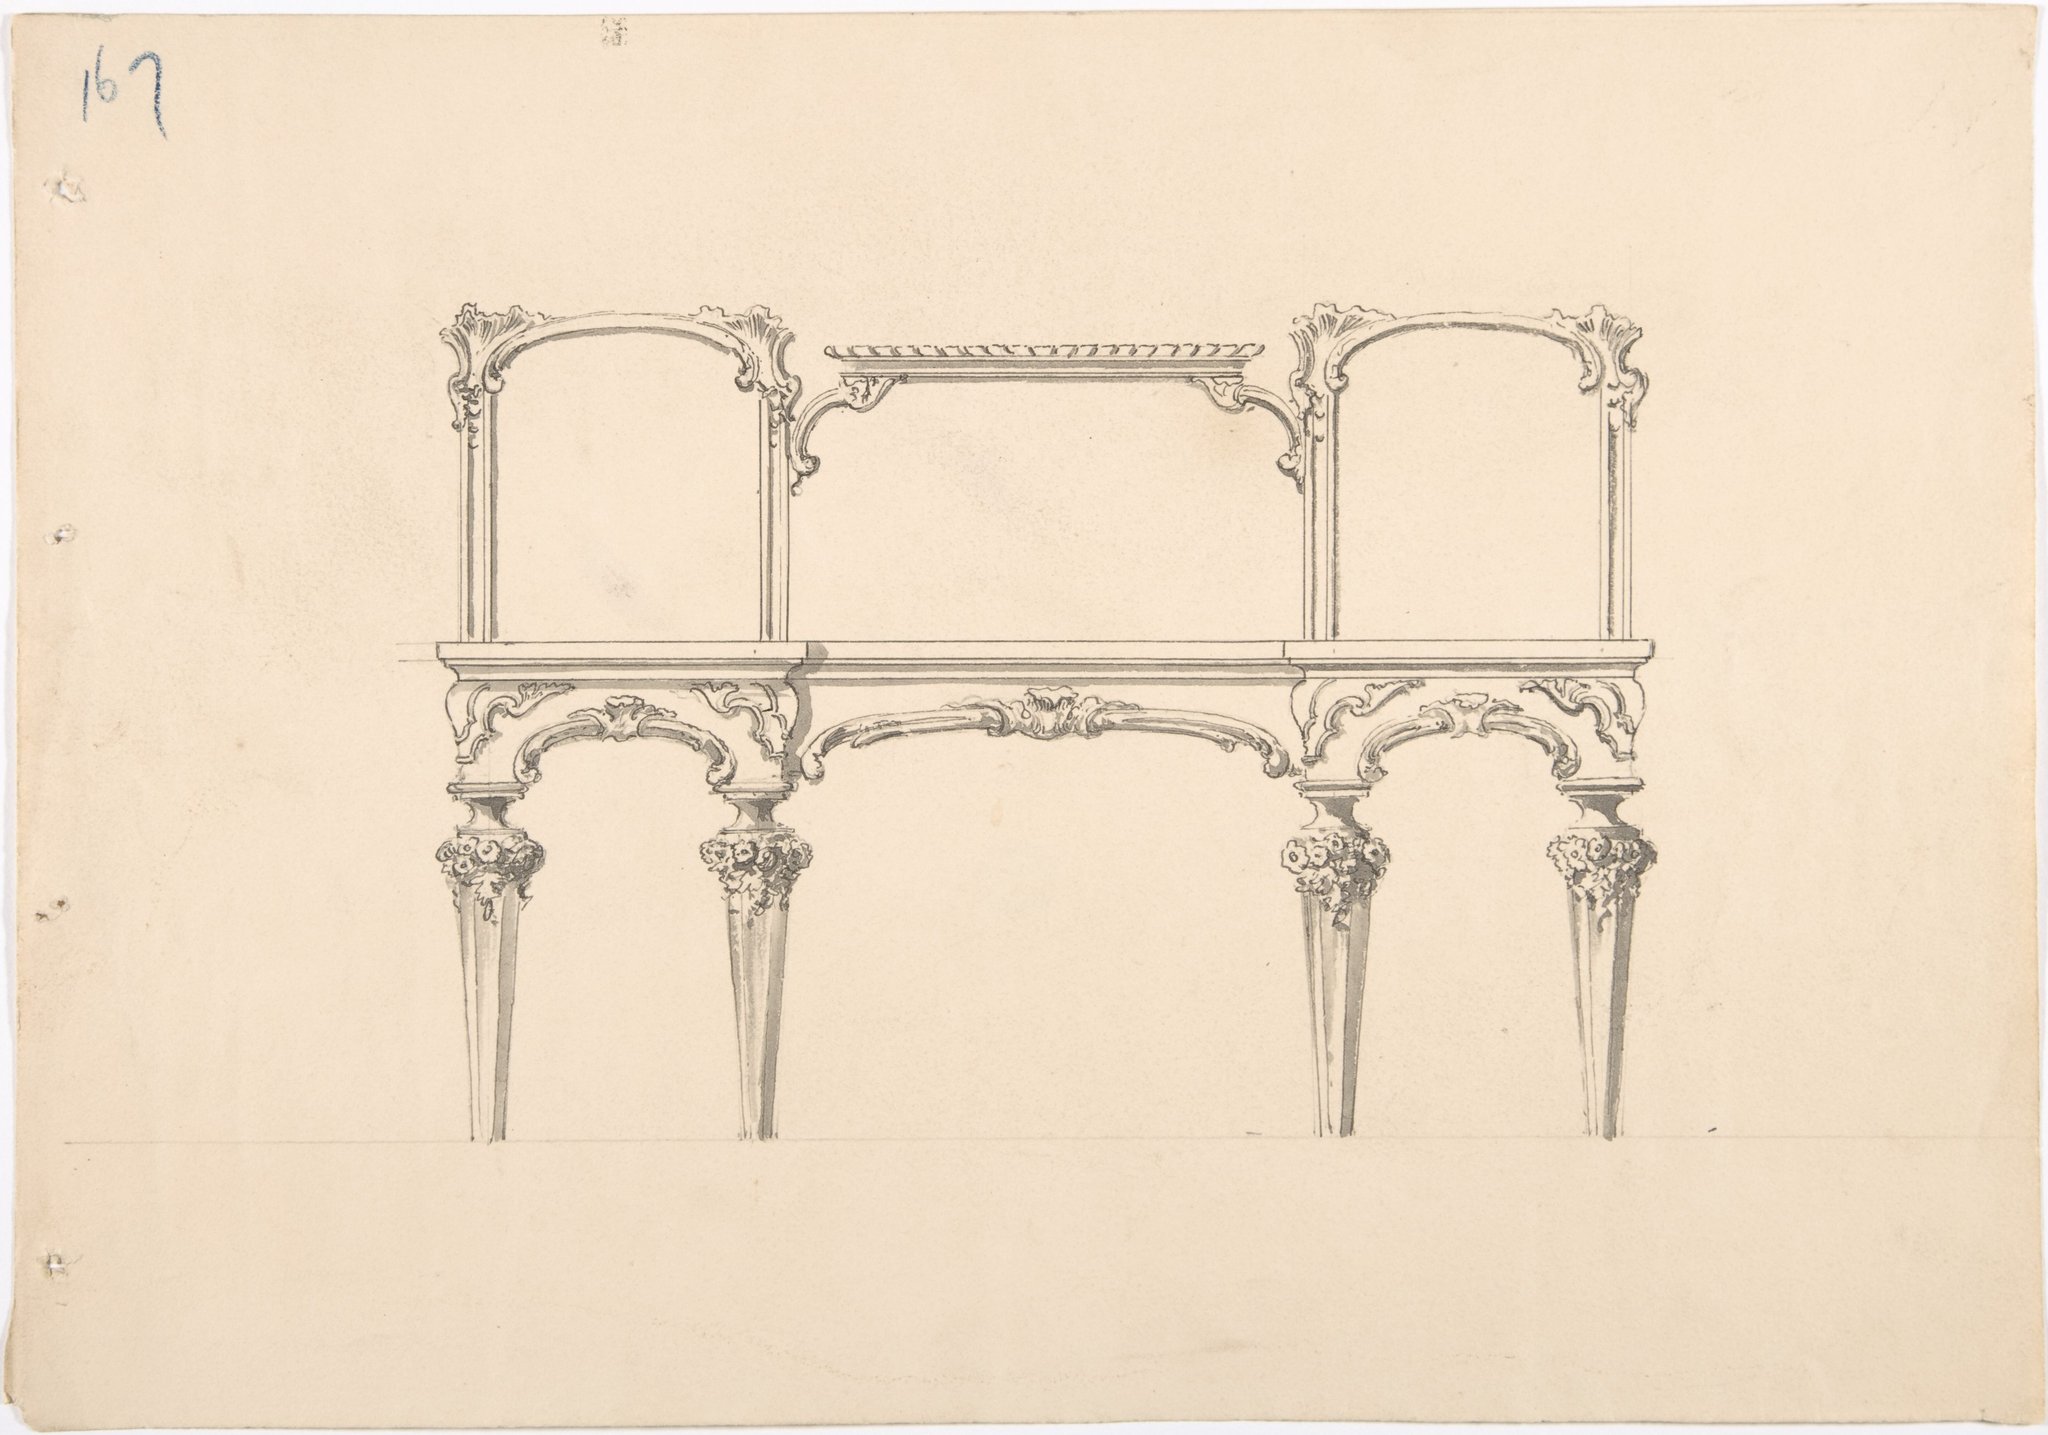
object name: drawing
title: Design for a Mirrored Sideboard with Diminishing Legs, Floral and Rocaille Ornament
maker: anonymous, british, 19th century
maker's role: artist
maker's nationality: british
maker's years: 1800-1900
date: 1801-1833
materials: ink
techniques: brush, pen, wash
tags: flowers,leaves,mirrors